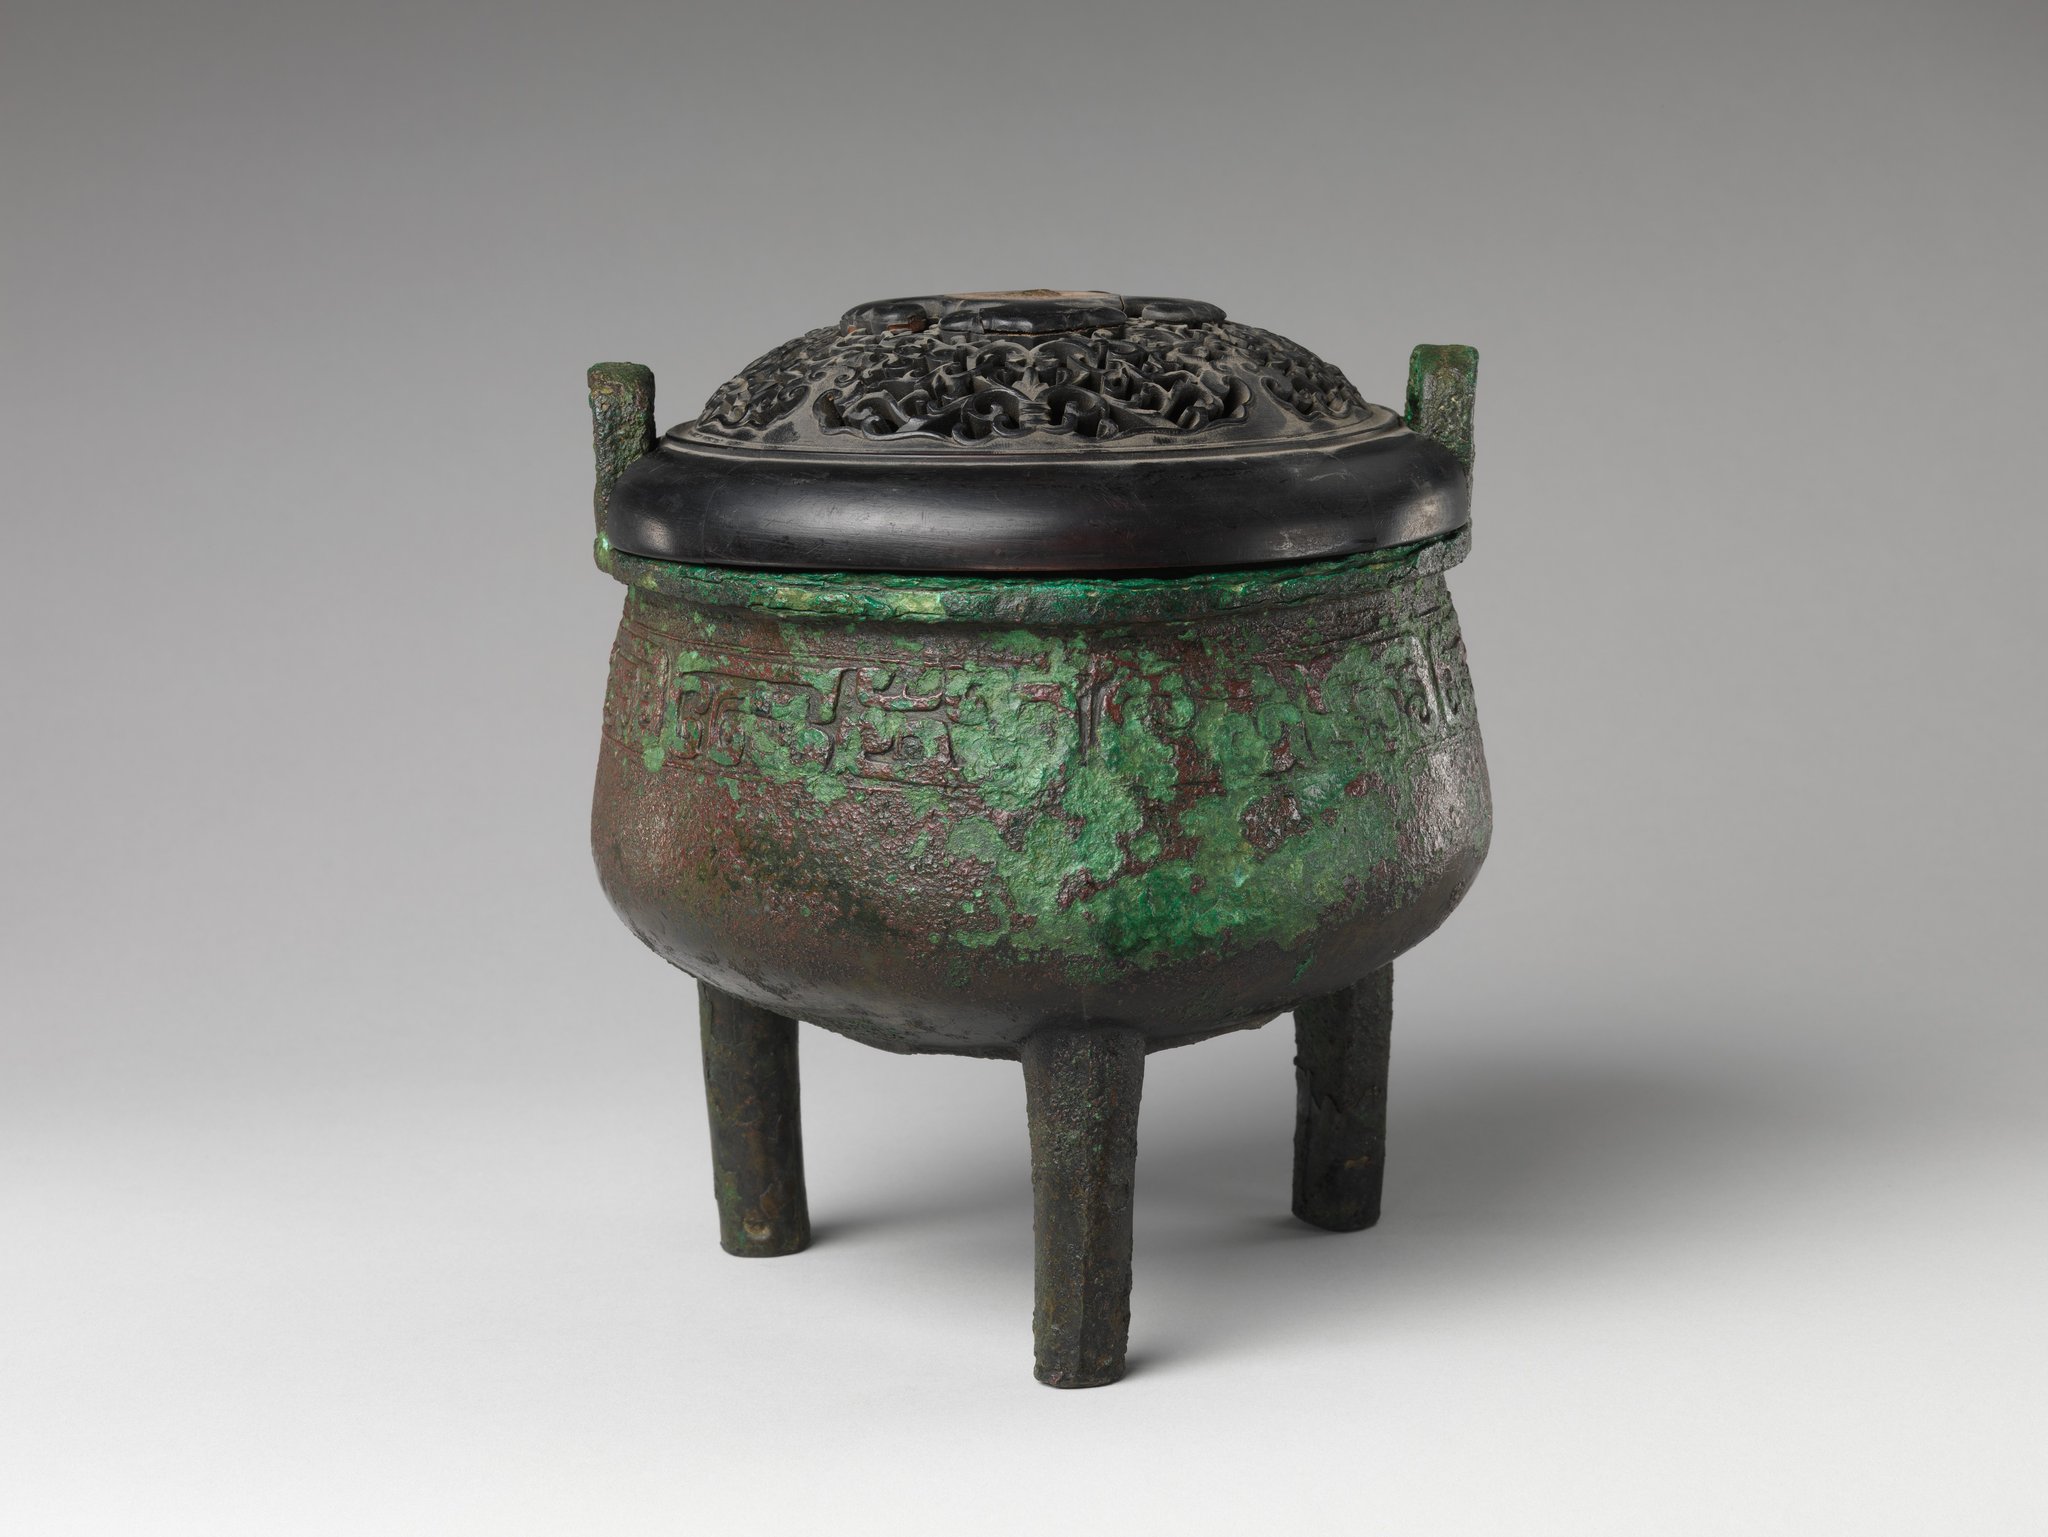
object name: cauldron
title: Tripod cauldron (ding) in ancient style?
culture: chinese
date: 1801-1900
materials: bronze